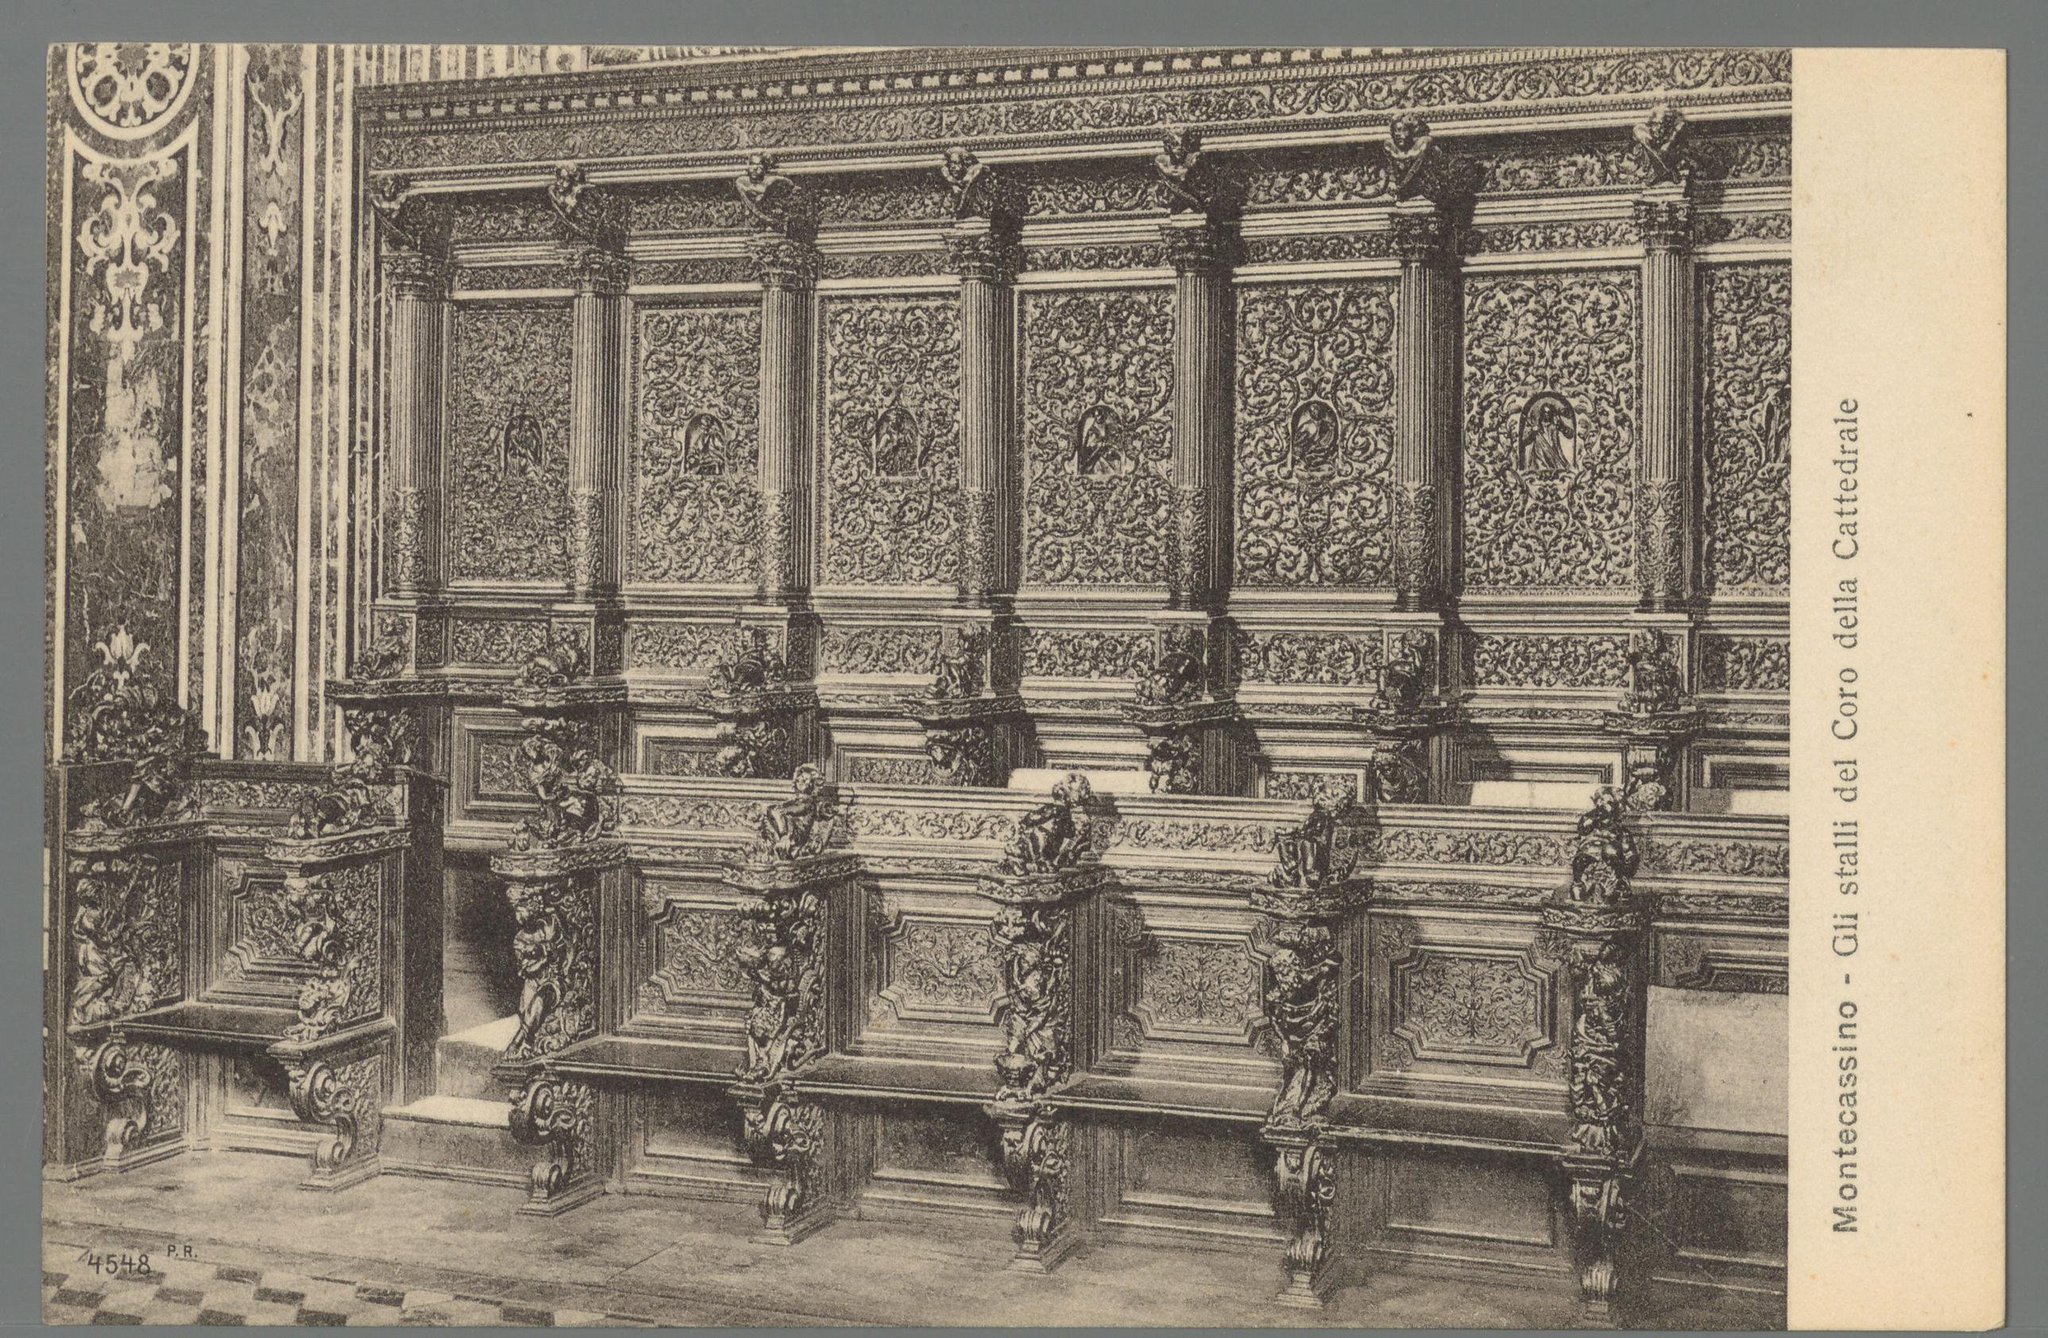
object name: photomechanical print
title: Montecassino. Gli stalli del Coro della Cattedrale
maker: Anonymous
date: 1906-1910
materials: cardboard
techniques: photograph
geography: terni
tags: abbey, monastery, convent ~ roman catholic church, parts of church interior: choir